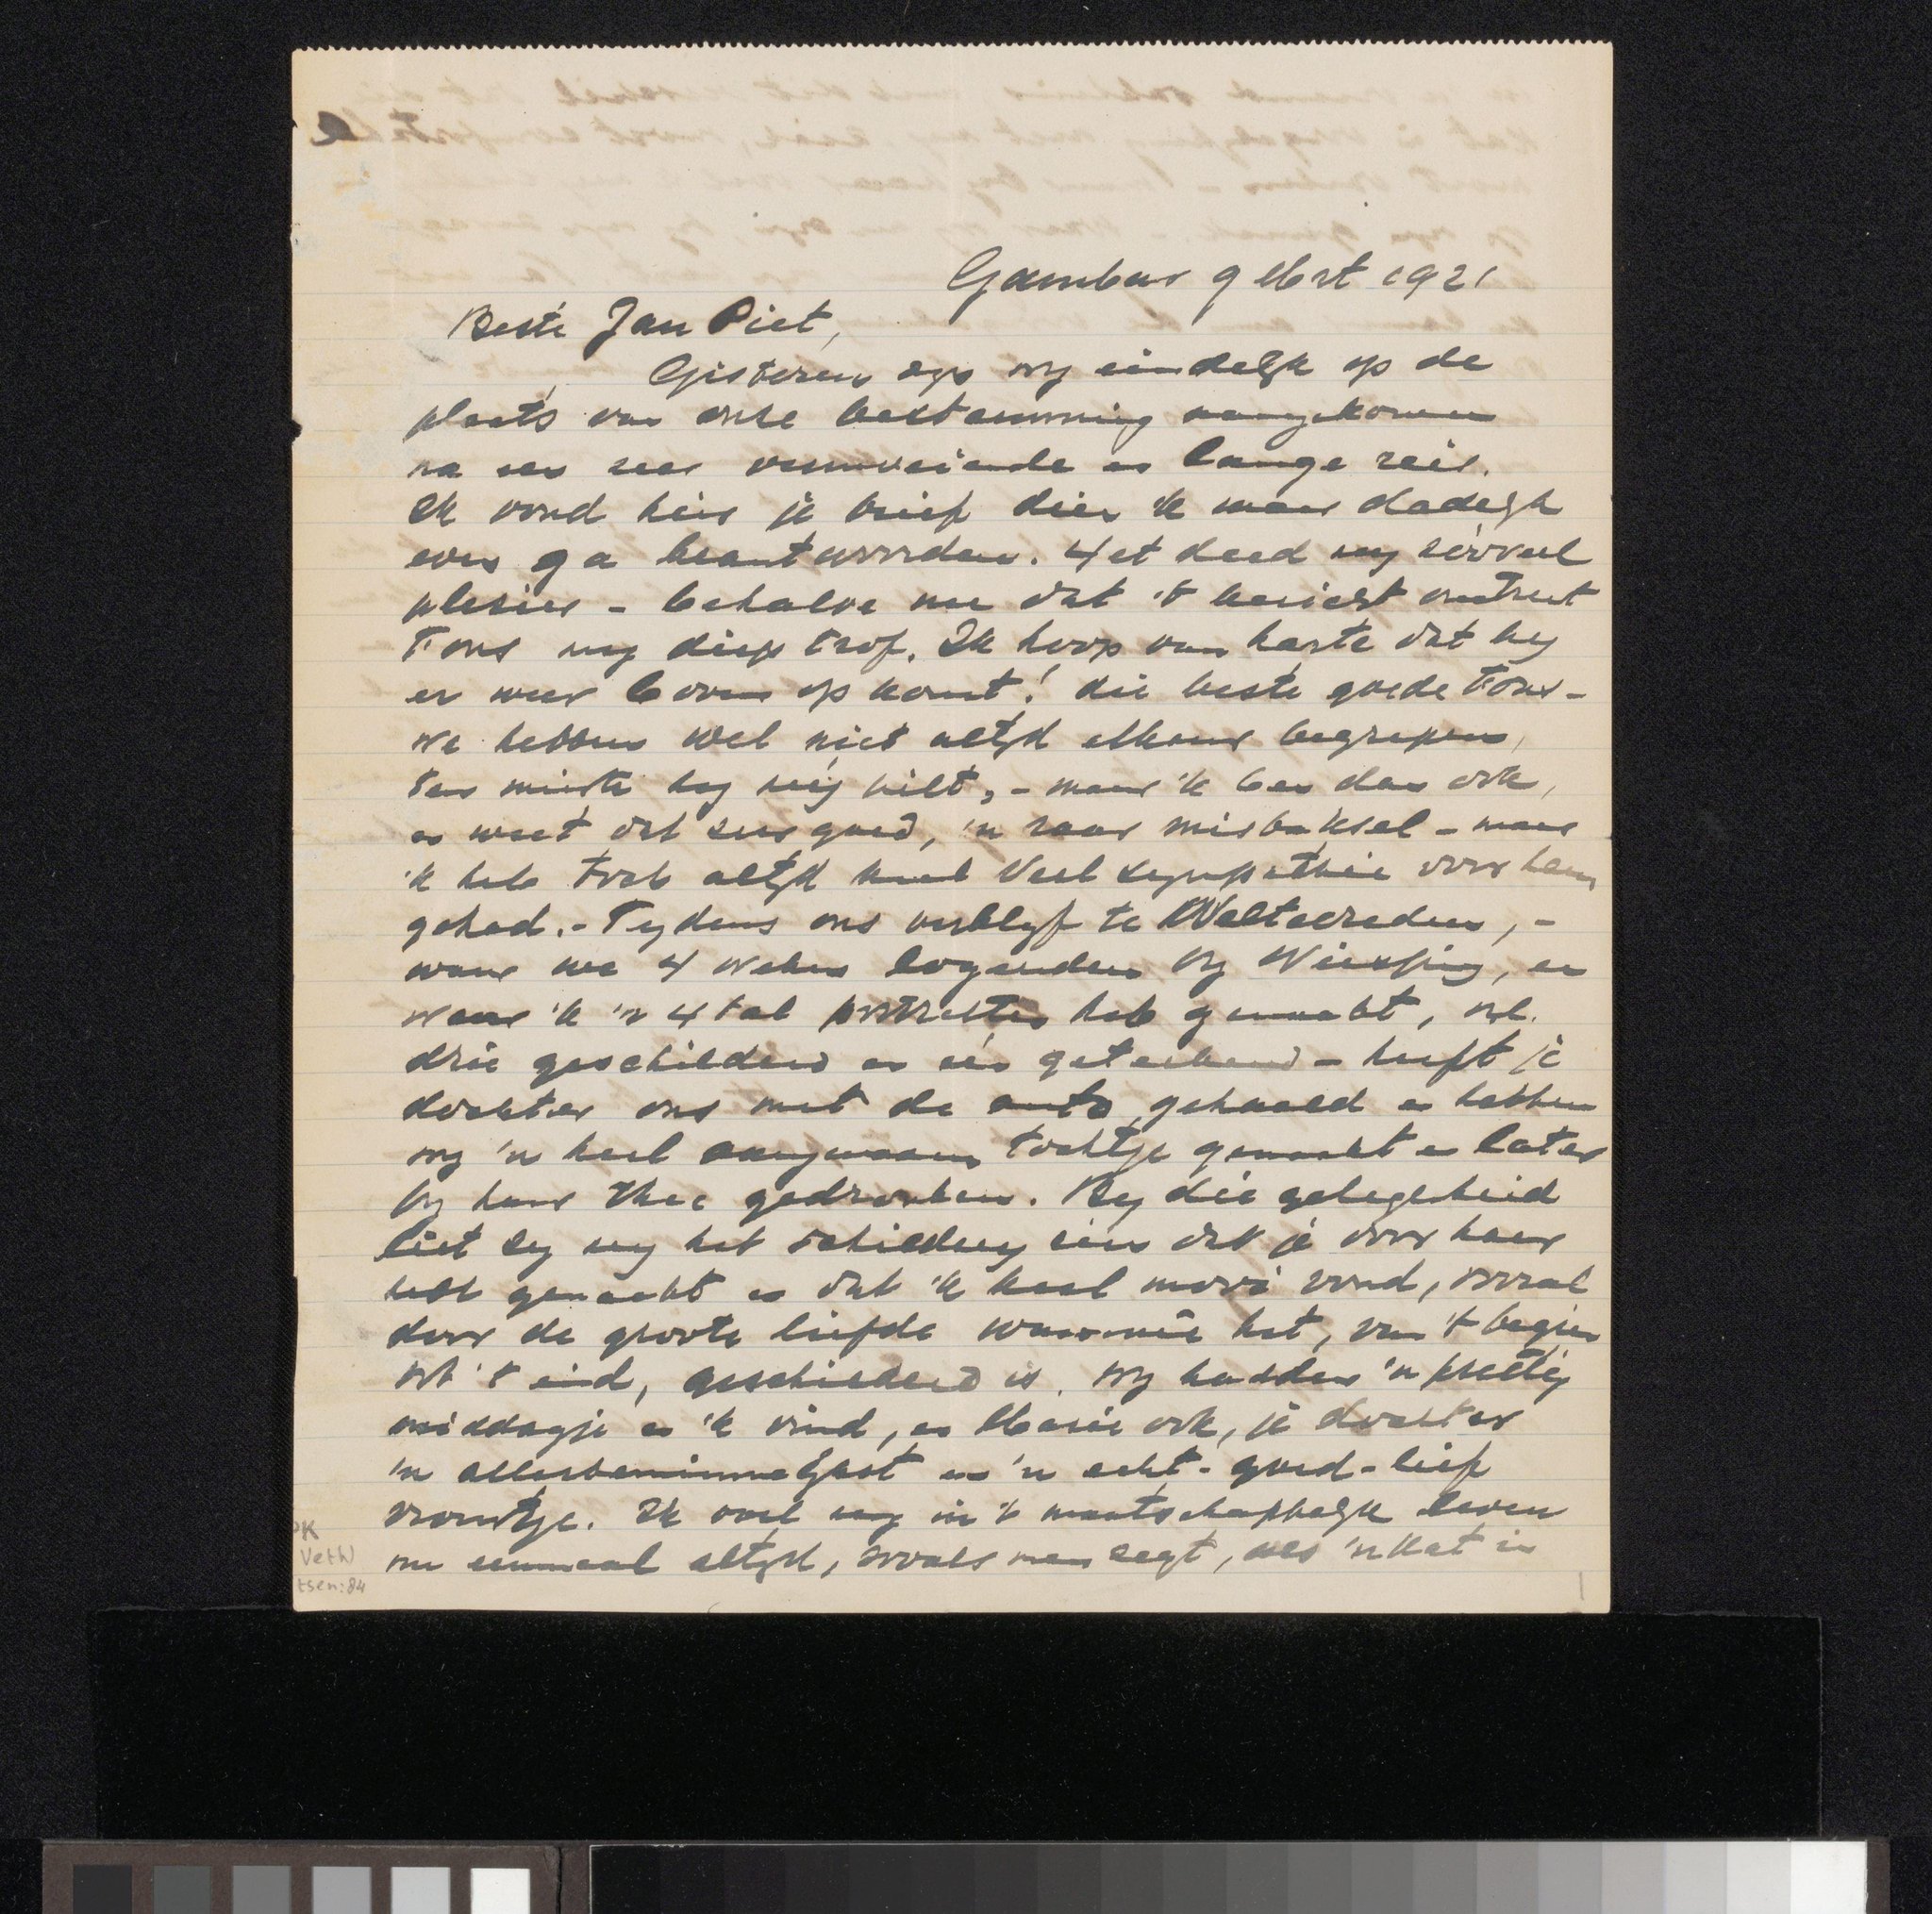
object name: letter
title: Brief aan Jan Veth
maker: willem witsen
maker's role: draughtsman, painter, print maker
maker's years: 1860-1923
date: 1921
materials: ink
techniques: pen, writing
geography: east java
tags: johan willem teillers, dordrecht, designer, jan veth, the hague, drawing, travelling; tourism, painting (including book-illumination, miniature-painting), exhibition ~ art, historical persons (portraits and scenes from the life), batavia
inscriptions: collector's mark: ‘RPK’